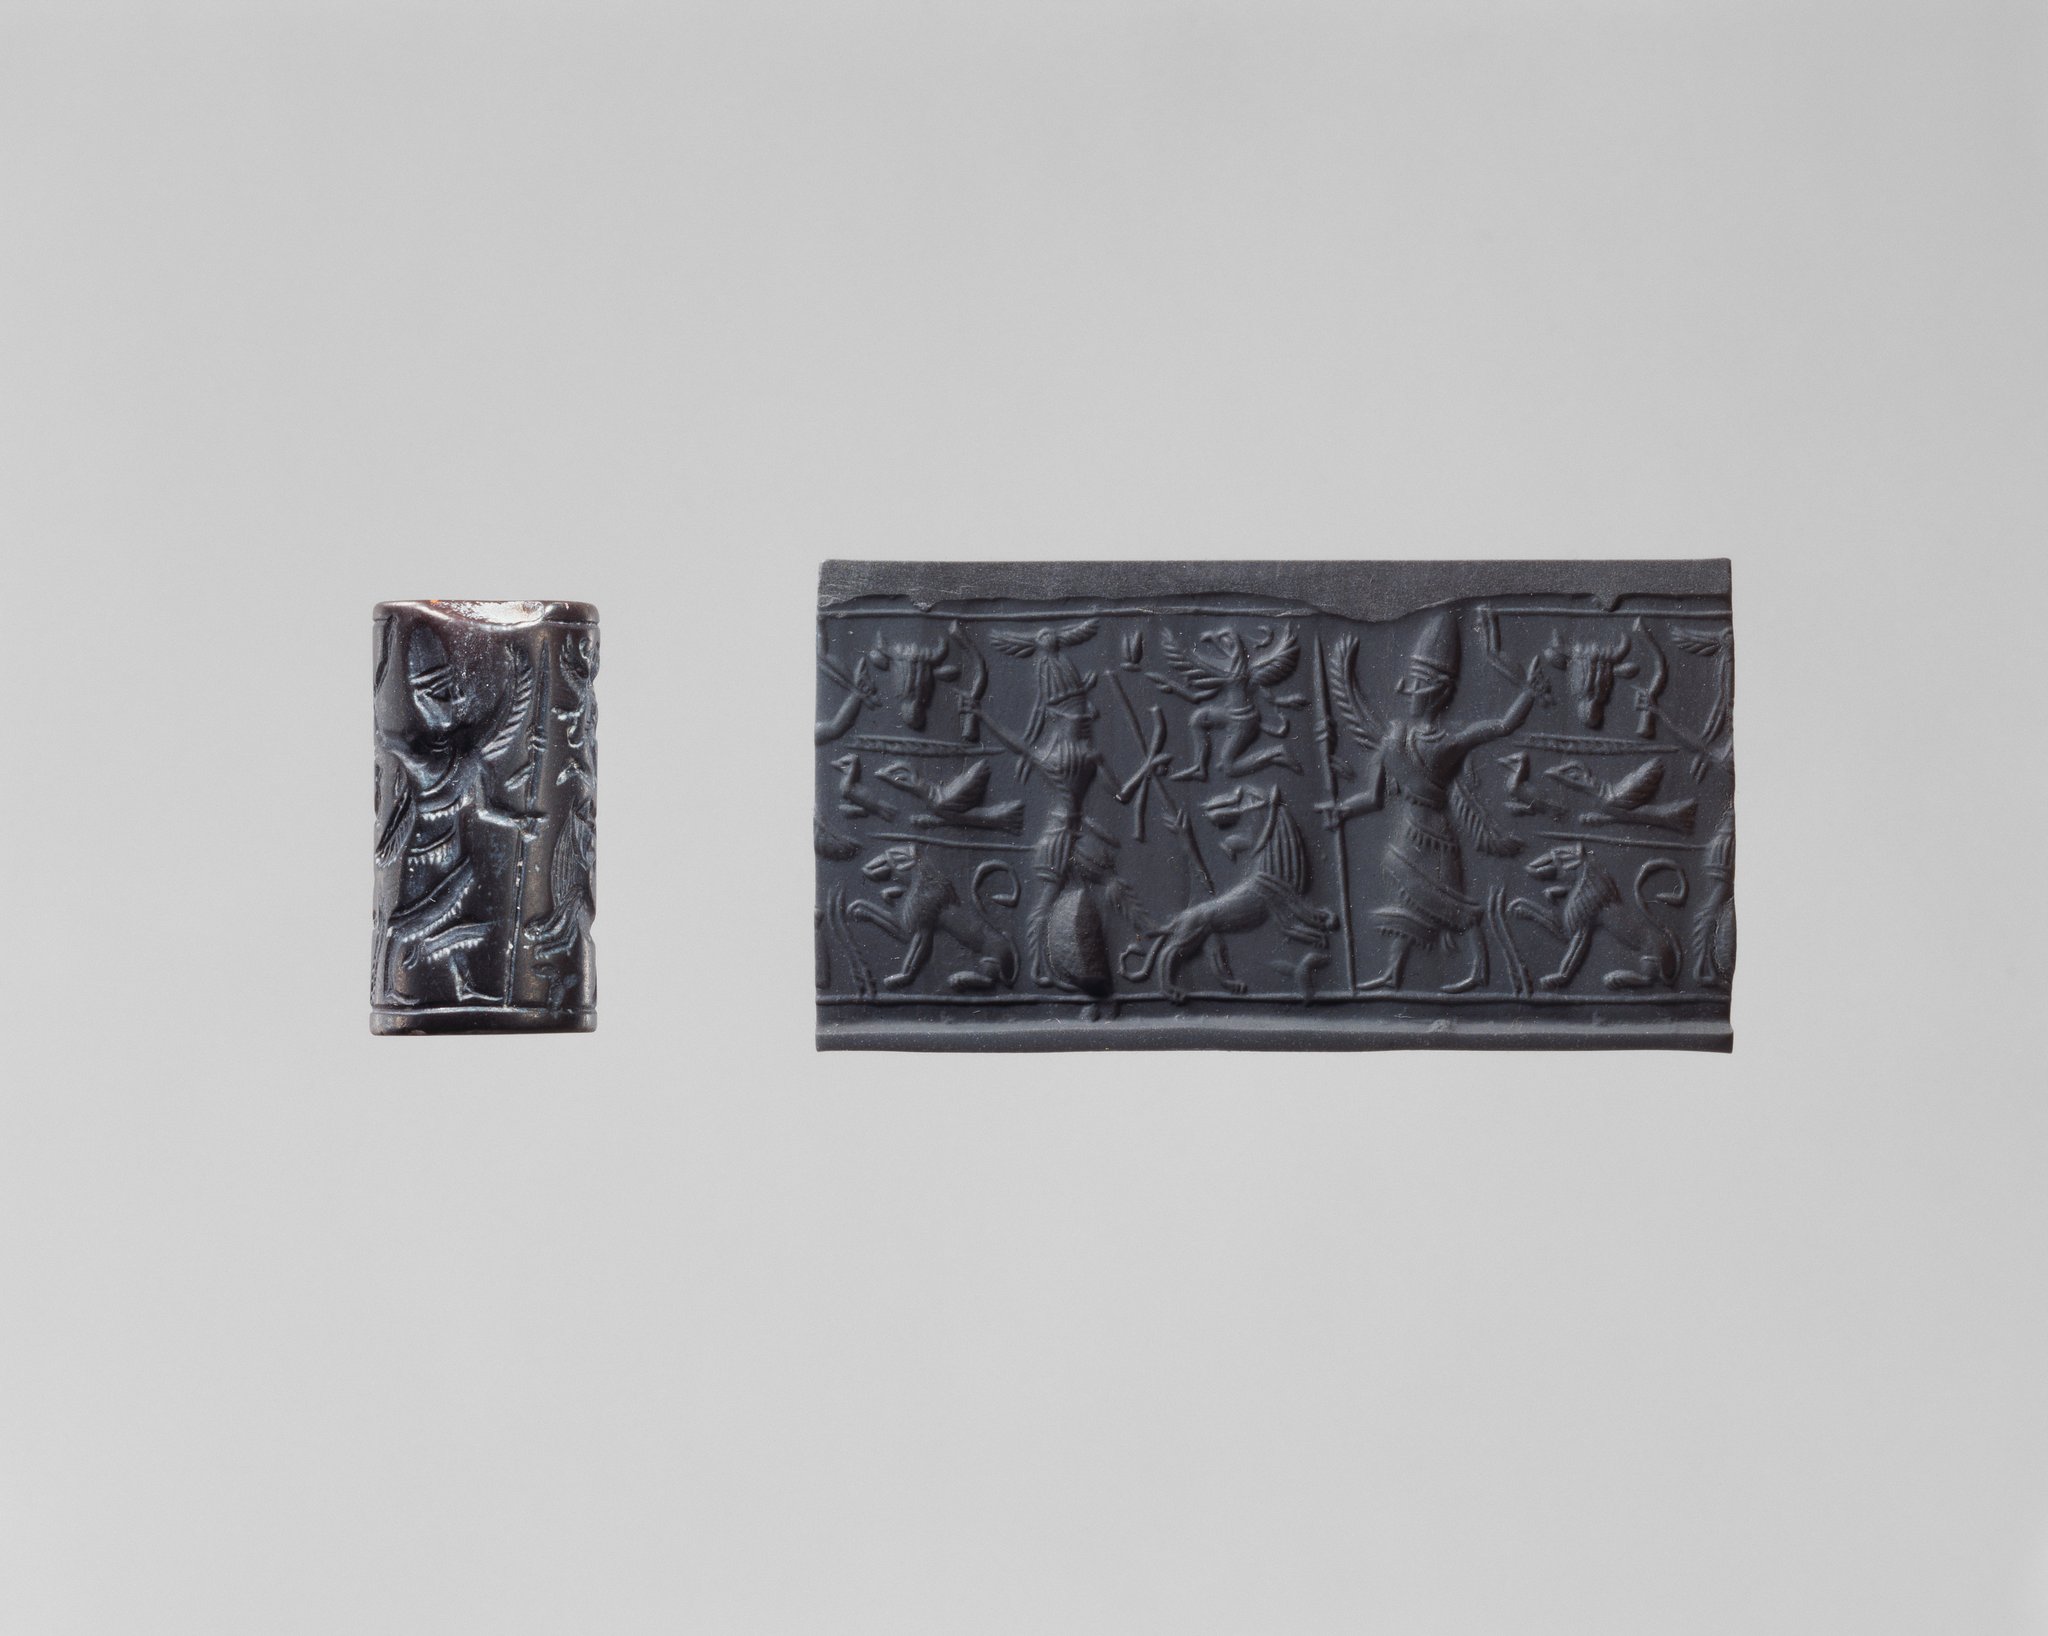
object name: cylinder seal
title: Cylinder seal and modern impression: hunter spearing a lion before deity with staff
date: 1700-1601 BCE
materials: mineral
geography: cyprus or syria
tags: birds,spears,hunting,lions